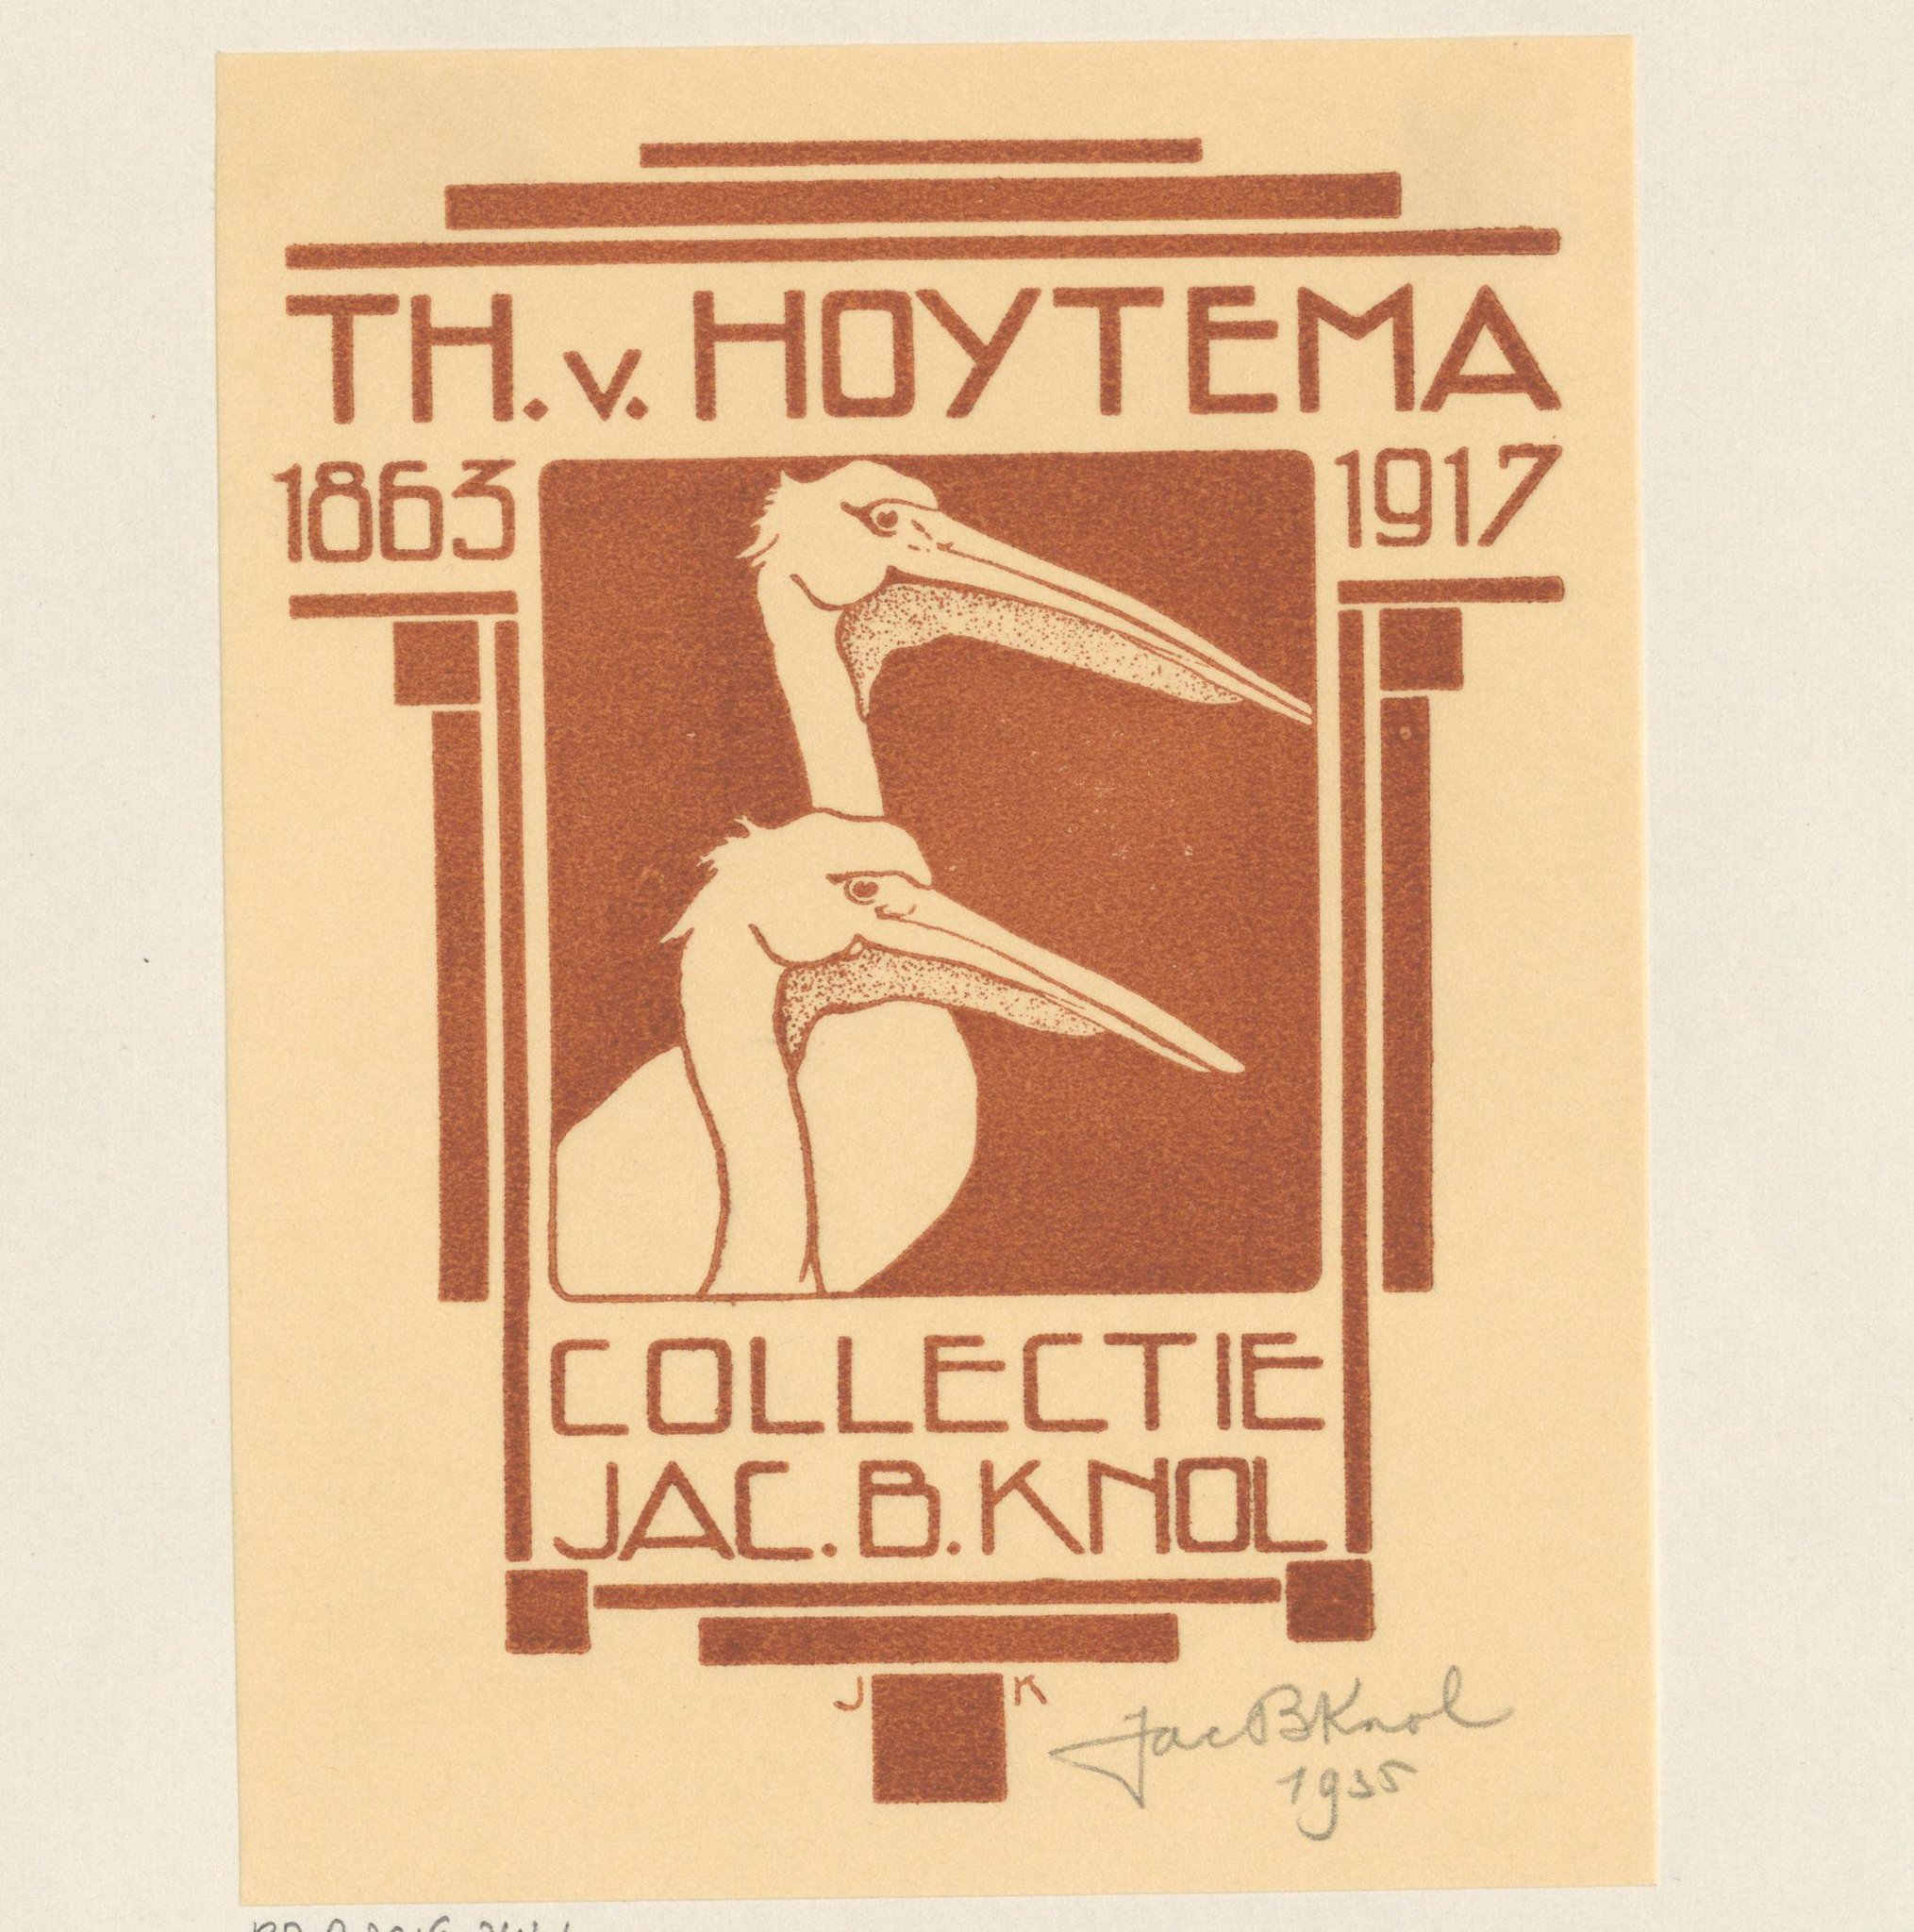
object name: bookplate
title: Ex libris van de Collectie Jac. B. Knol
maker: jac. b. knol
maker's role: verzamelaar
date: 1935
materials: paper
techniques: printing block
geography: netherlands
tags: jac. b. knol, the hague, painter, print maker, draughtsman, theo van hoytema, water-birds: pelican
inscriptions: signature and date: ‘Jac B Knol / 1935’